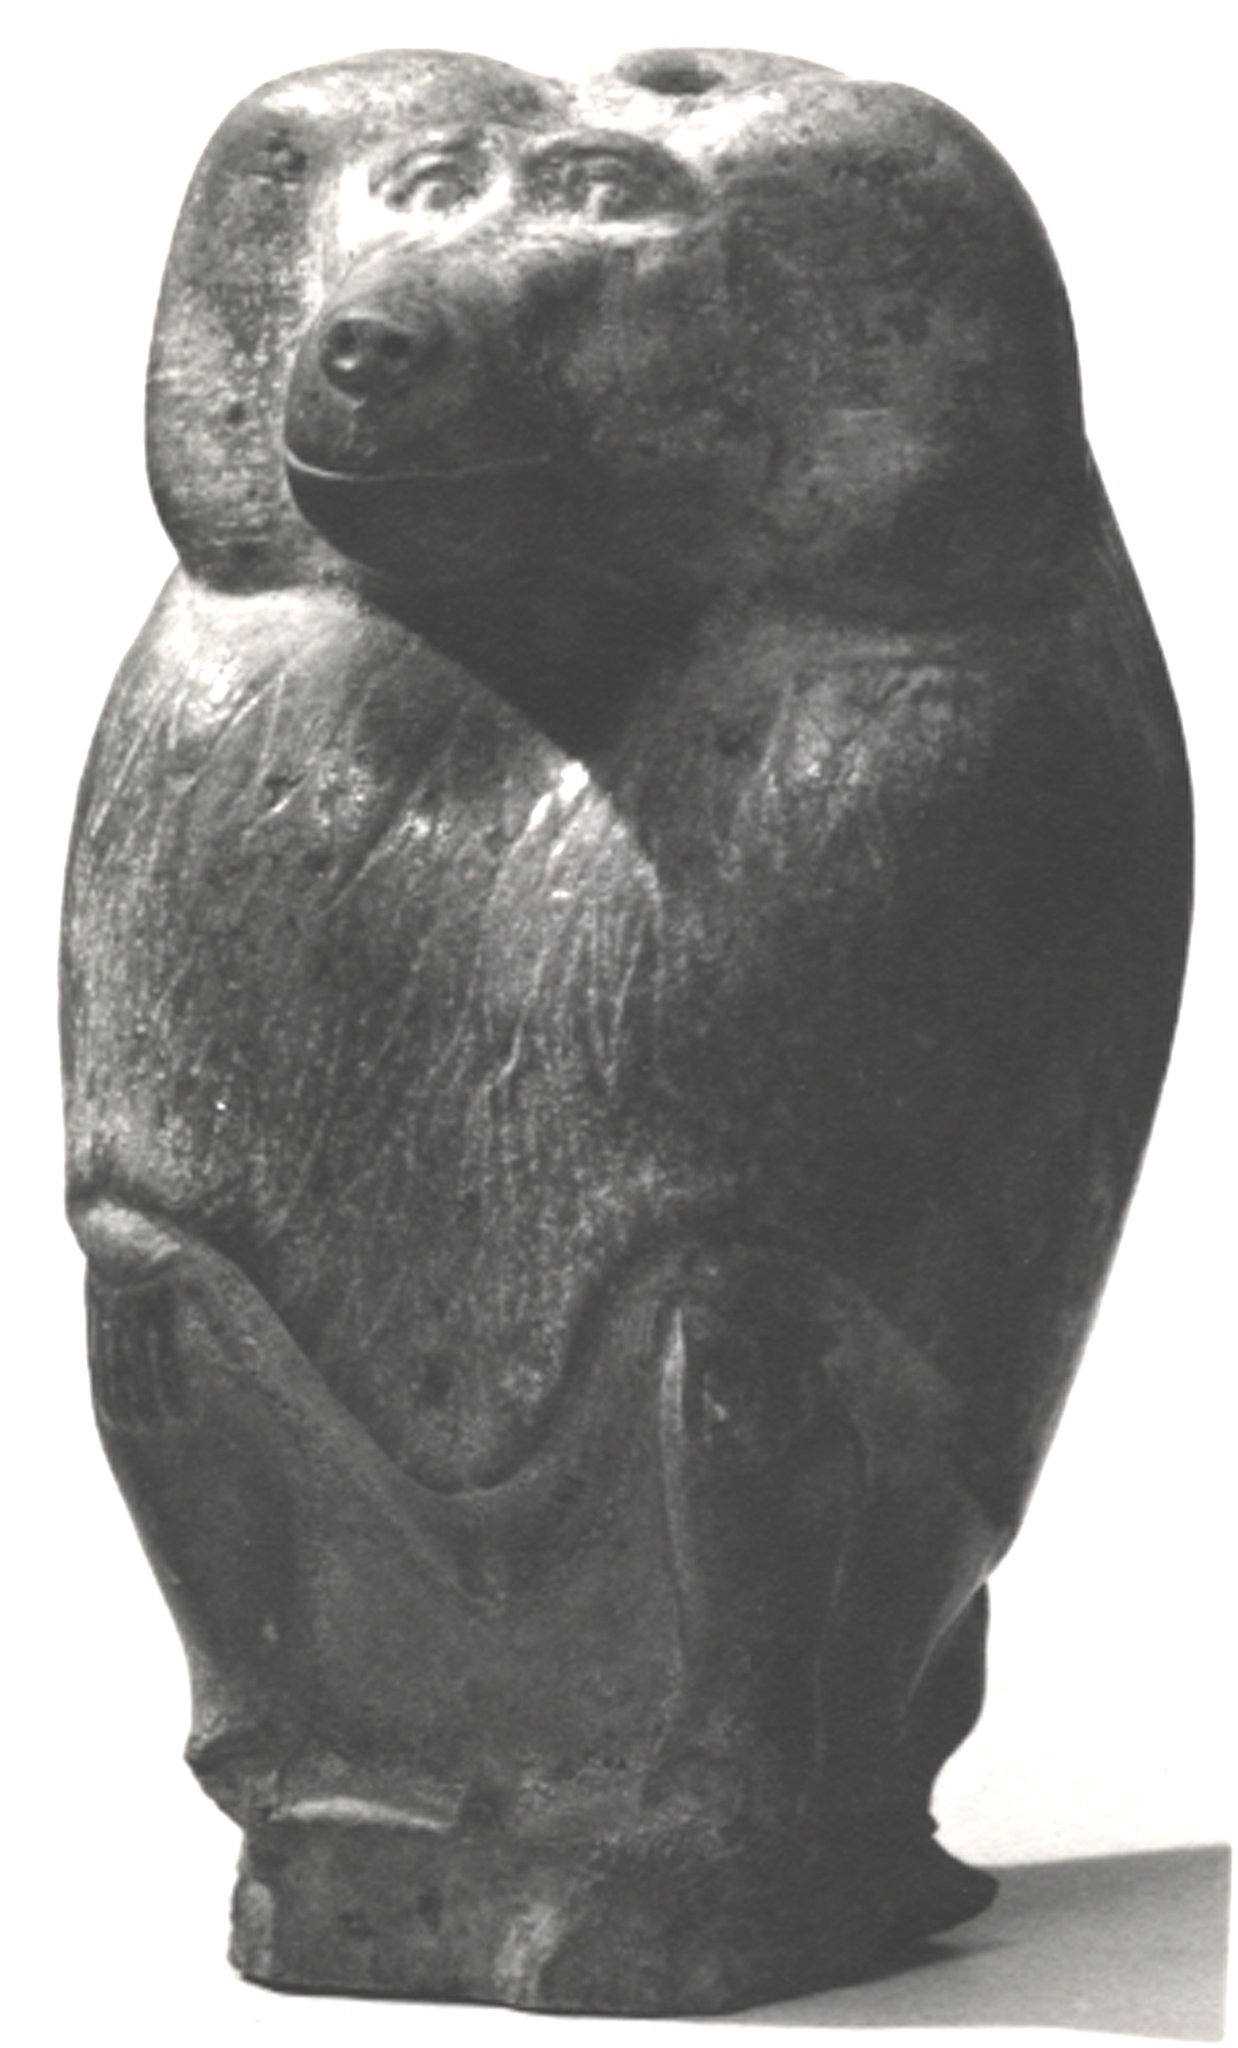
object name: figurine, baboon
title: Baboon figurine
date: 2030-1640 BCE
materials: stone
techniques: glazing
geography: egypt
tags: baboons